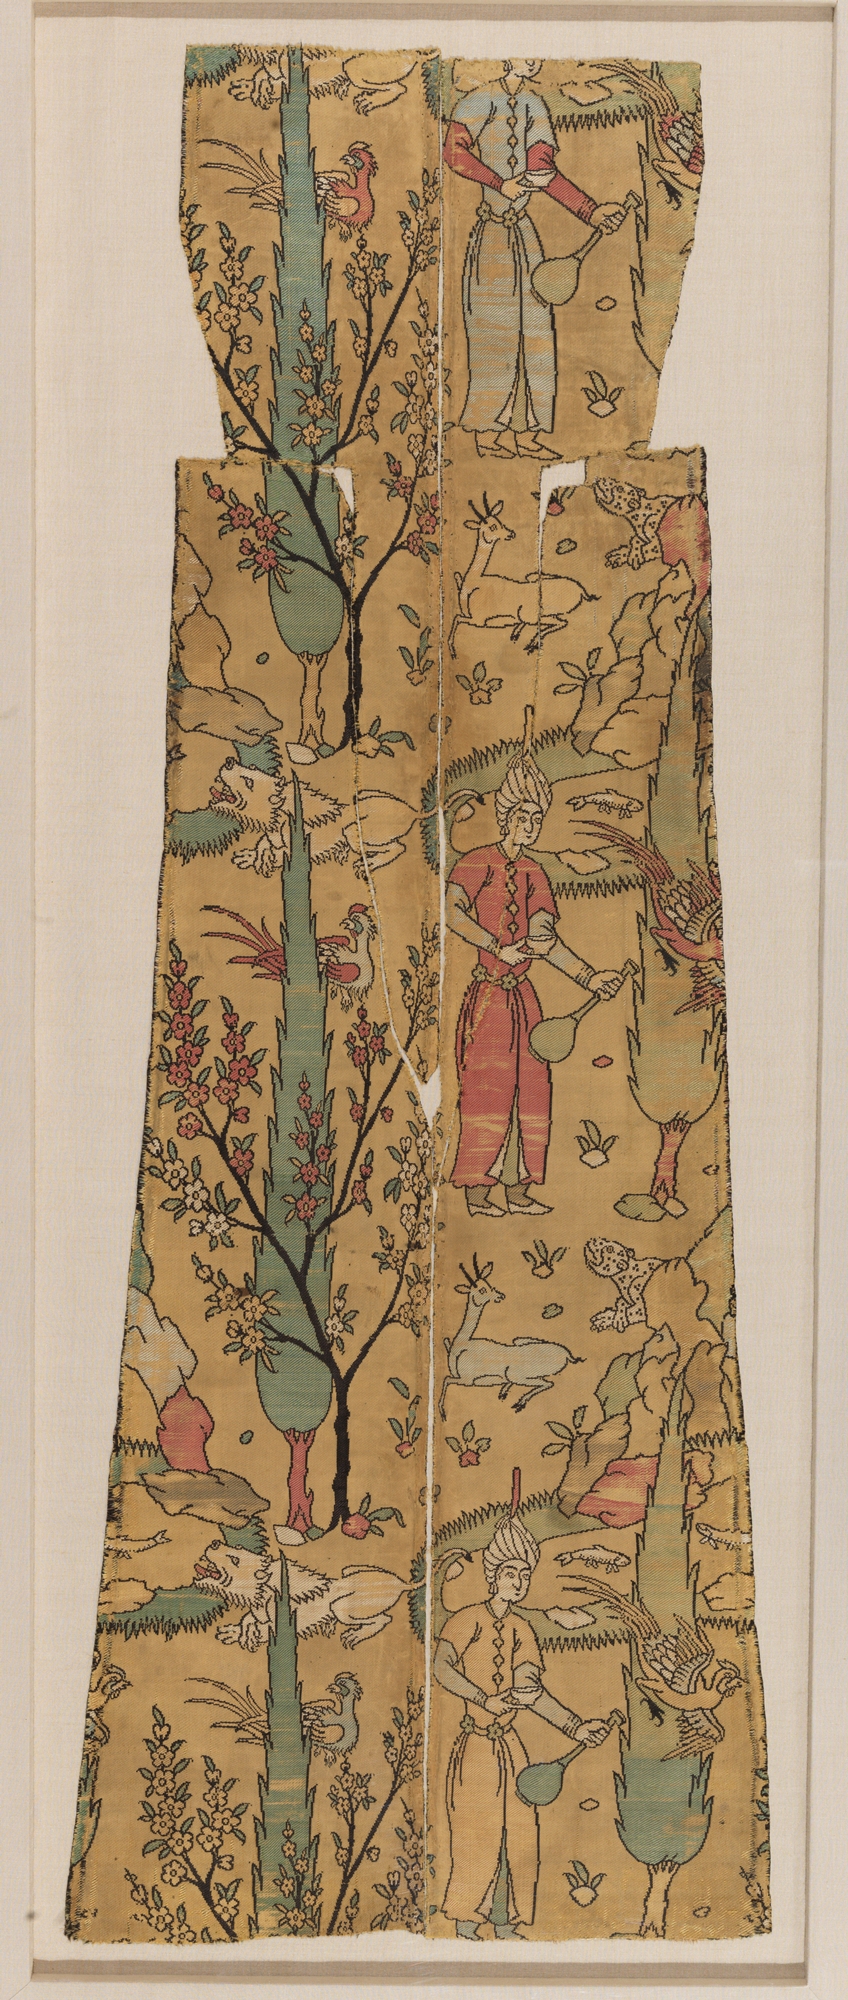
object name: textile fragment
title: Textile Fragment Depicting a Figure in a Landscape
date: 1501-1600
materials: silk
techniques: lampas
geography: iran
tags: birds,men,fish,lions,landscapes,trees